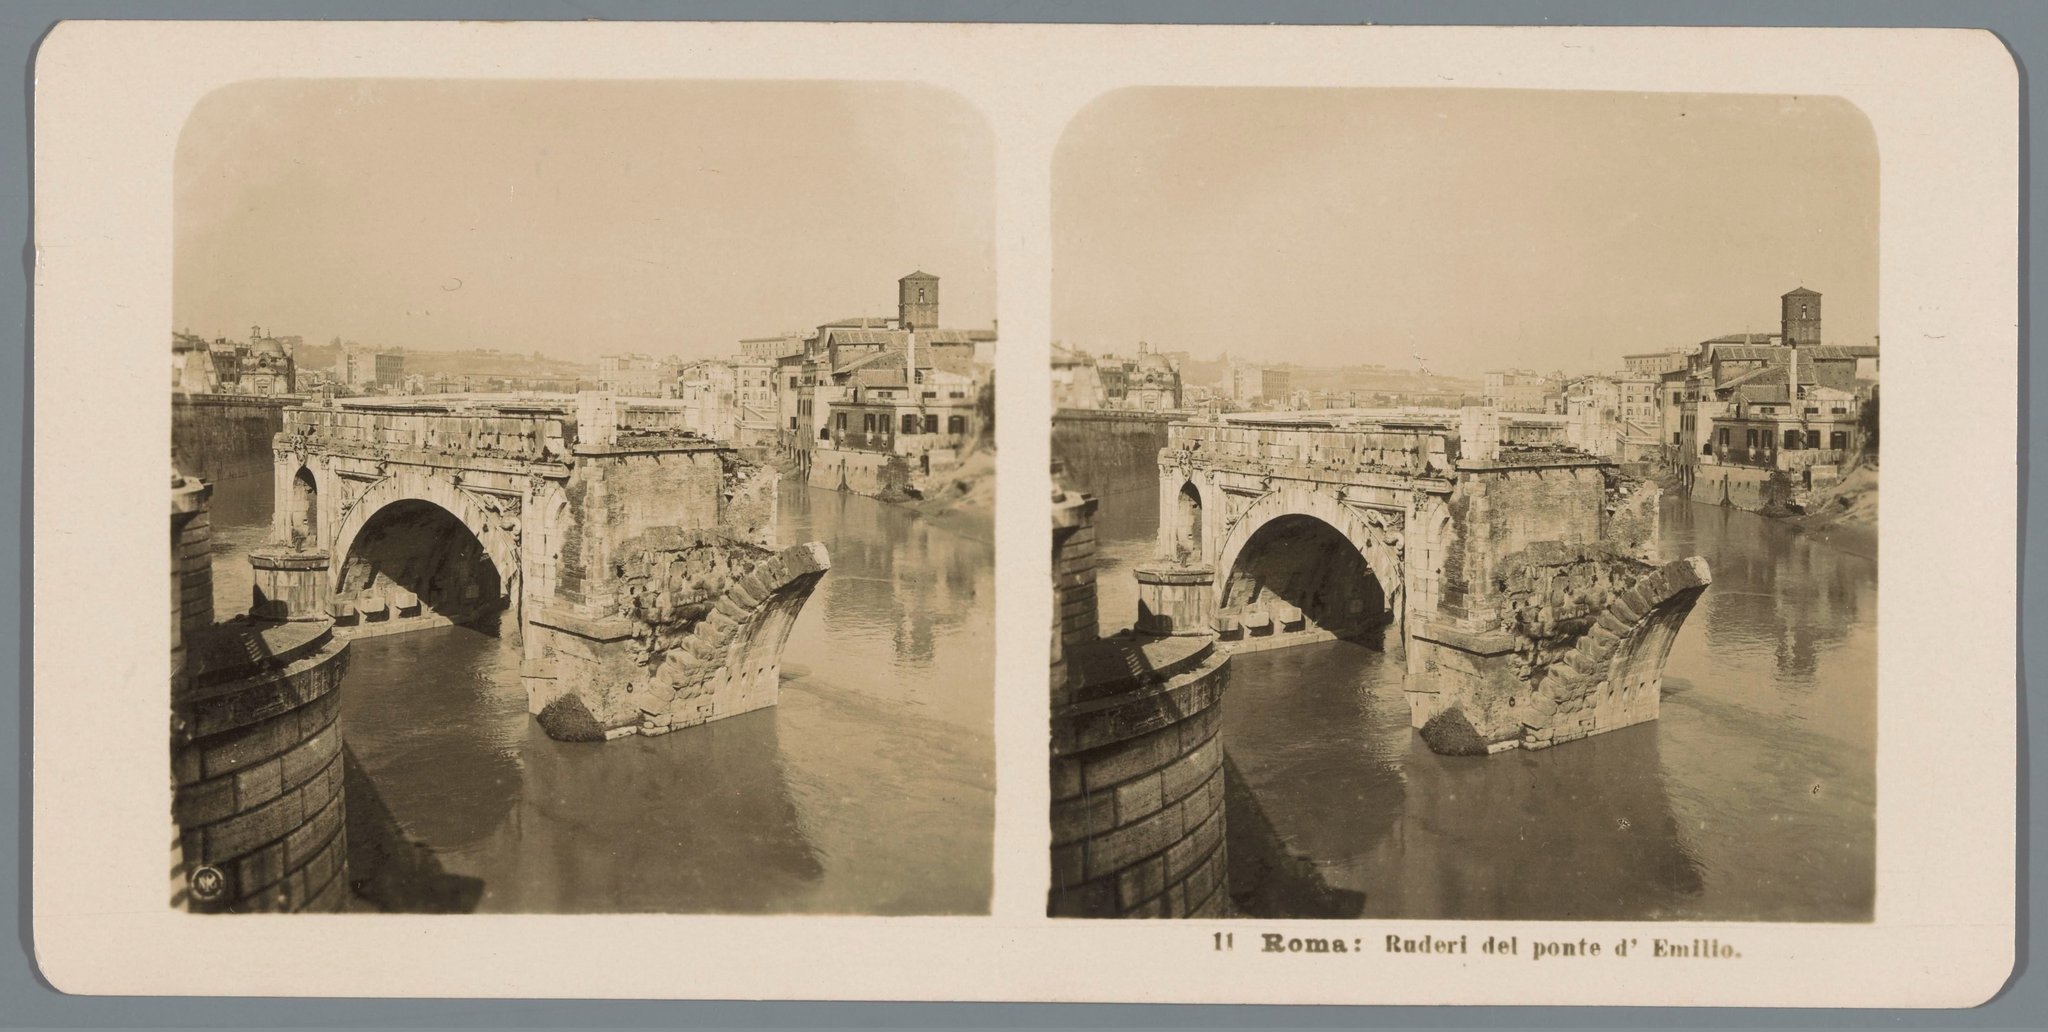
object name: stereograph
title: Roma: Ruderi del ponte d'Emilio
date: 1900-1910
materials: cardboard, photographic support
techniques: gelatin silver print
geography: rome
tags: ruin of a building ~ architecture, bridge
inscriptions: inscription: ‘NPG’, number: ‘11’